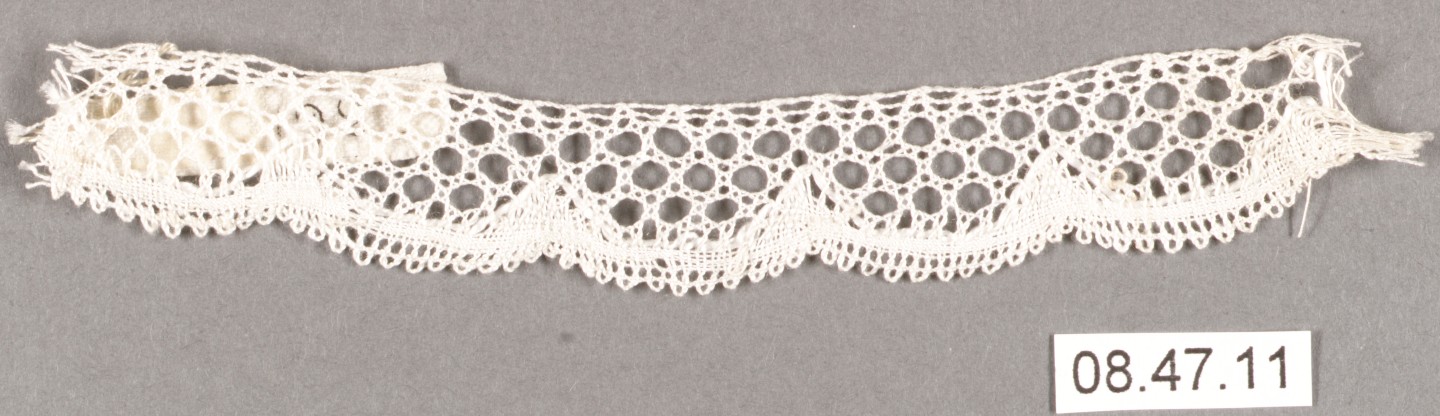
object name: fragment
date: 1801-1900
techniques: lace